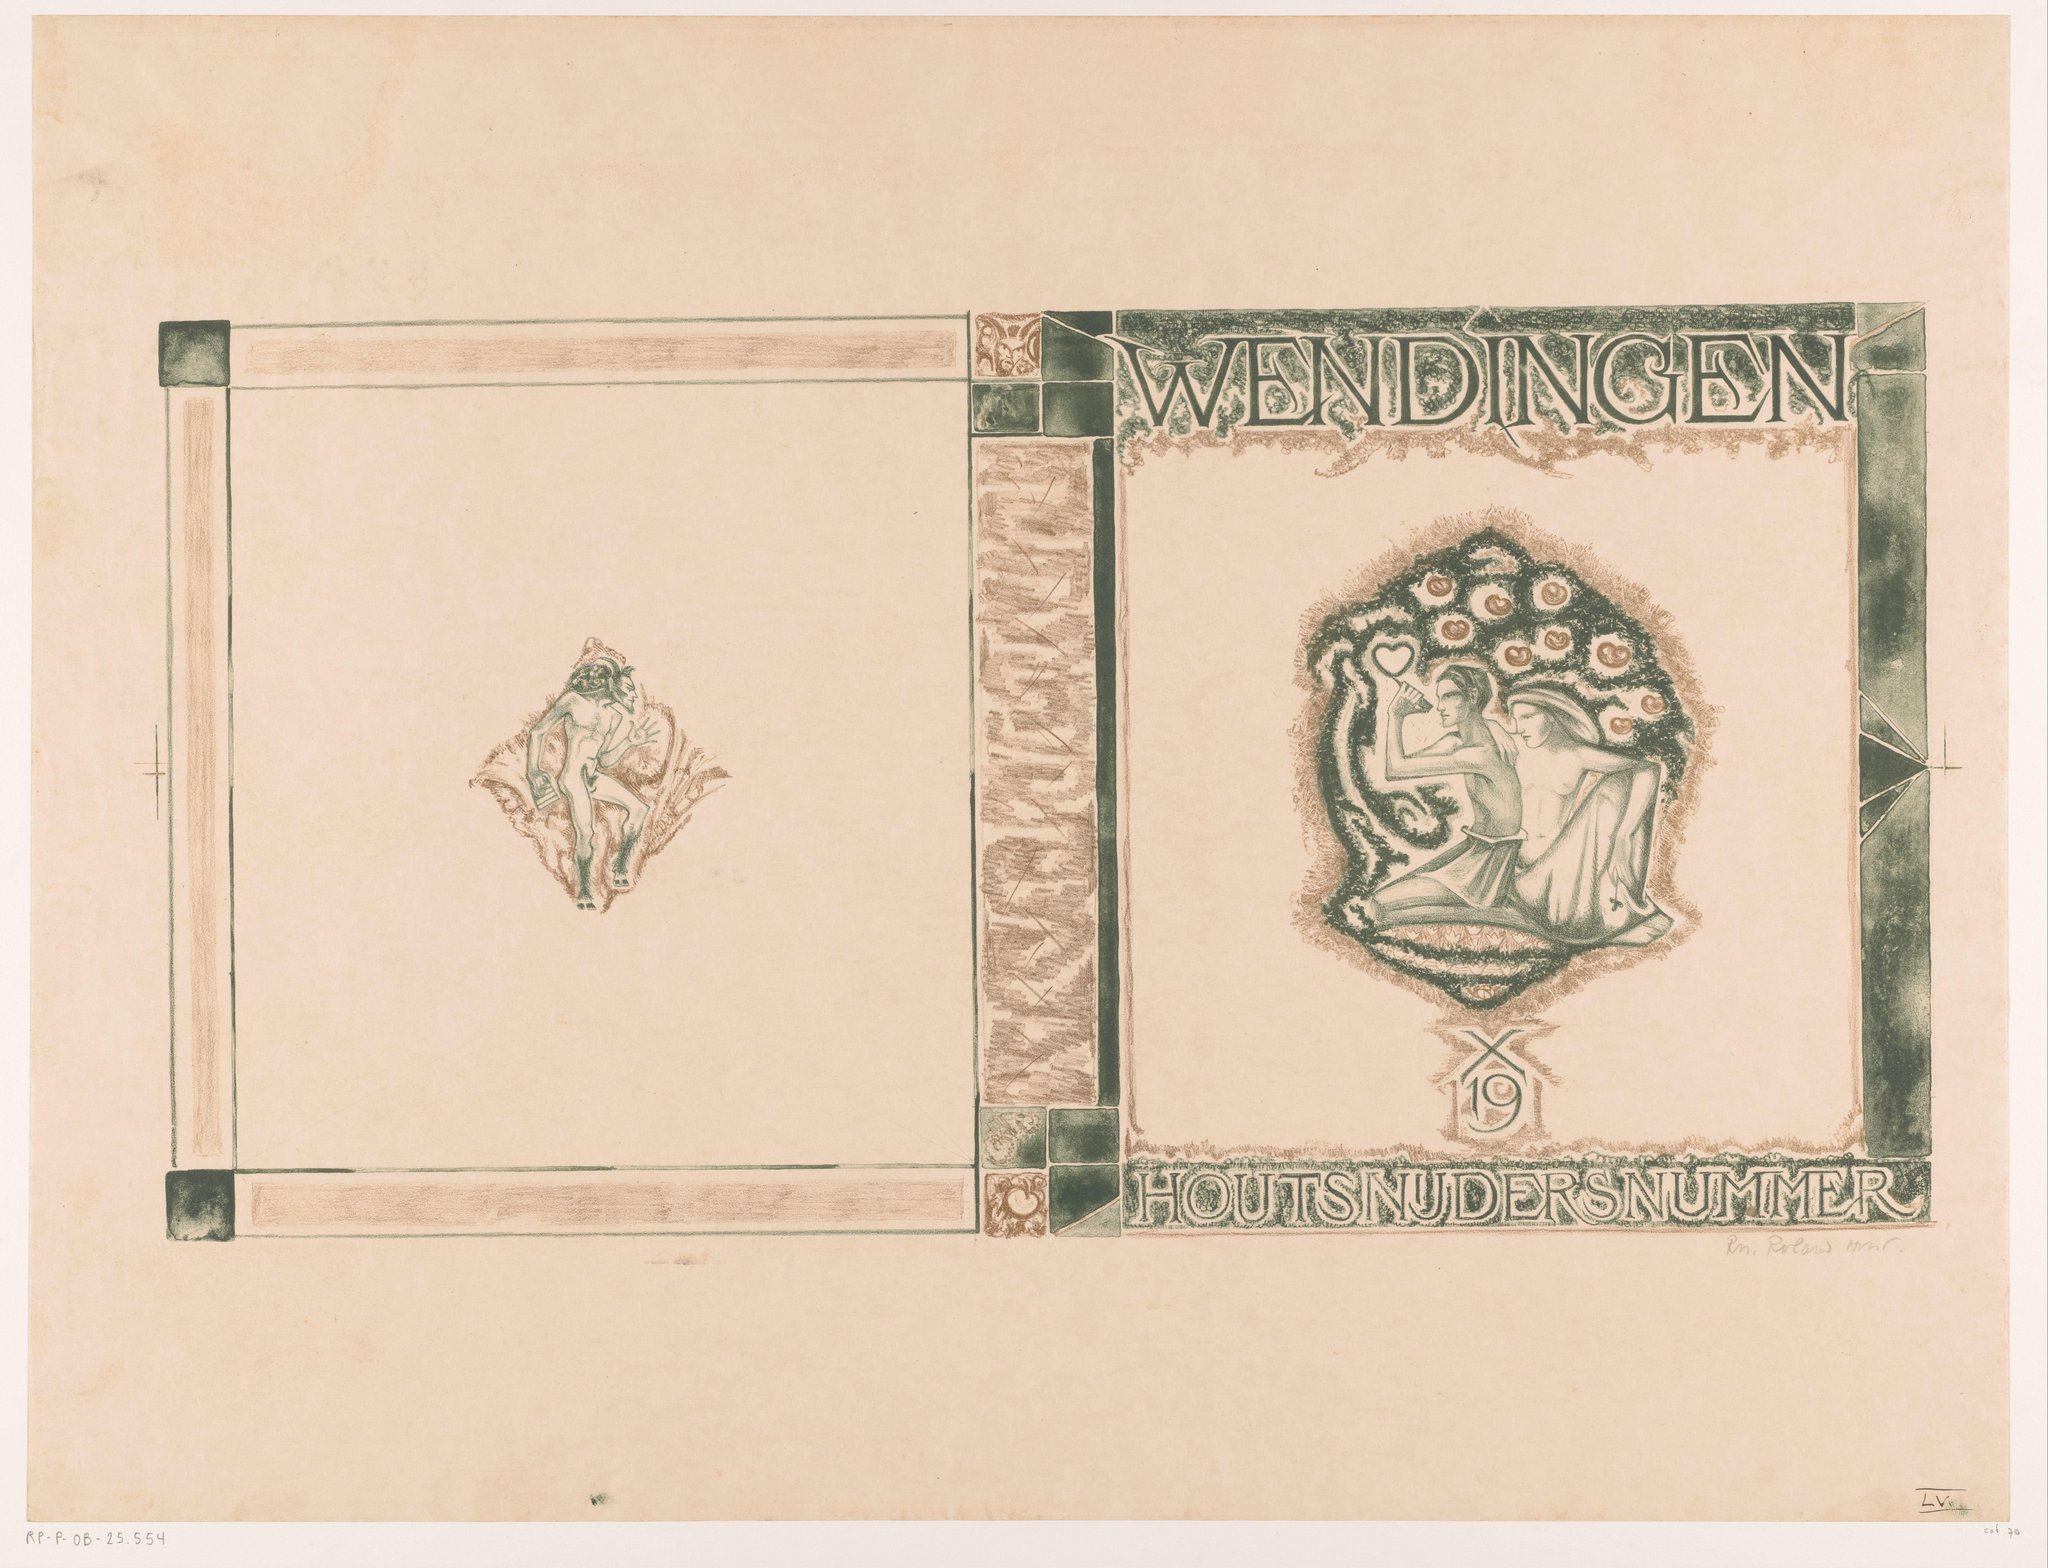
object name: design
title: Omslagontwerp voor: Wendingen, Houtsnijdersnummer, 1919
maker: richard nicolaüs roland holst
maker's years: 1868-1938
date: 1919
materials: paper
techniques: lithograph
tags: fruit-tree culture; fruit harvest, satyr(s) (in general), wood carver, carving heart and initials in an object, e.g. a tree trunk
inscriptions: collector's mark: Lugt 2228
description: Links een sater in een bos. Rechts een halfnaakte man en een vrouw, zittend bij een fruitboom. De man kerft een hart in de stam van de boom. De vrouw houdt een klaver vast in haar hand.